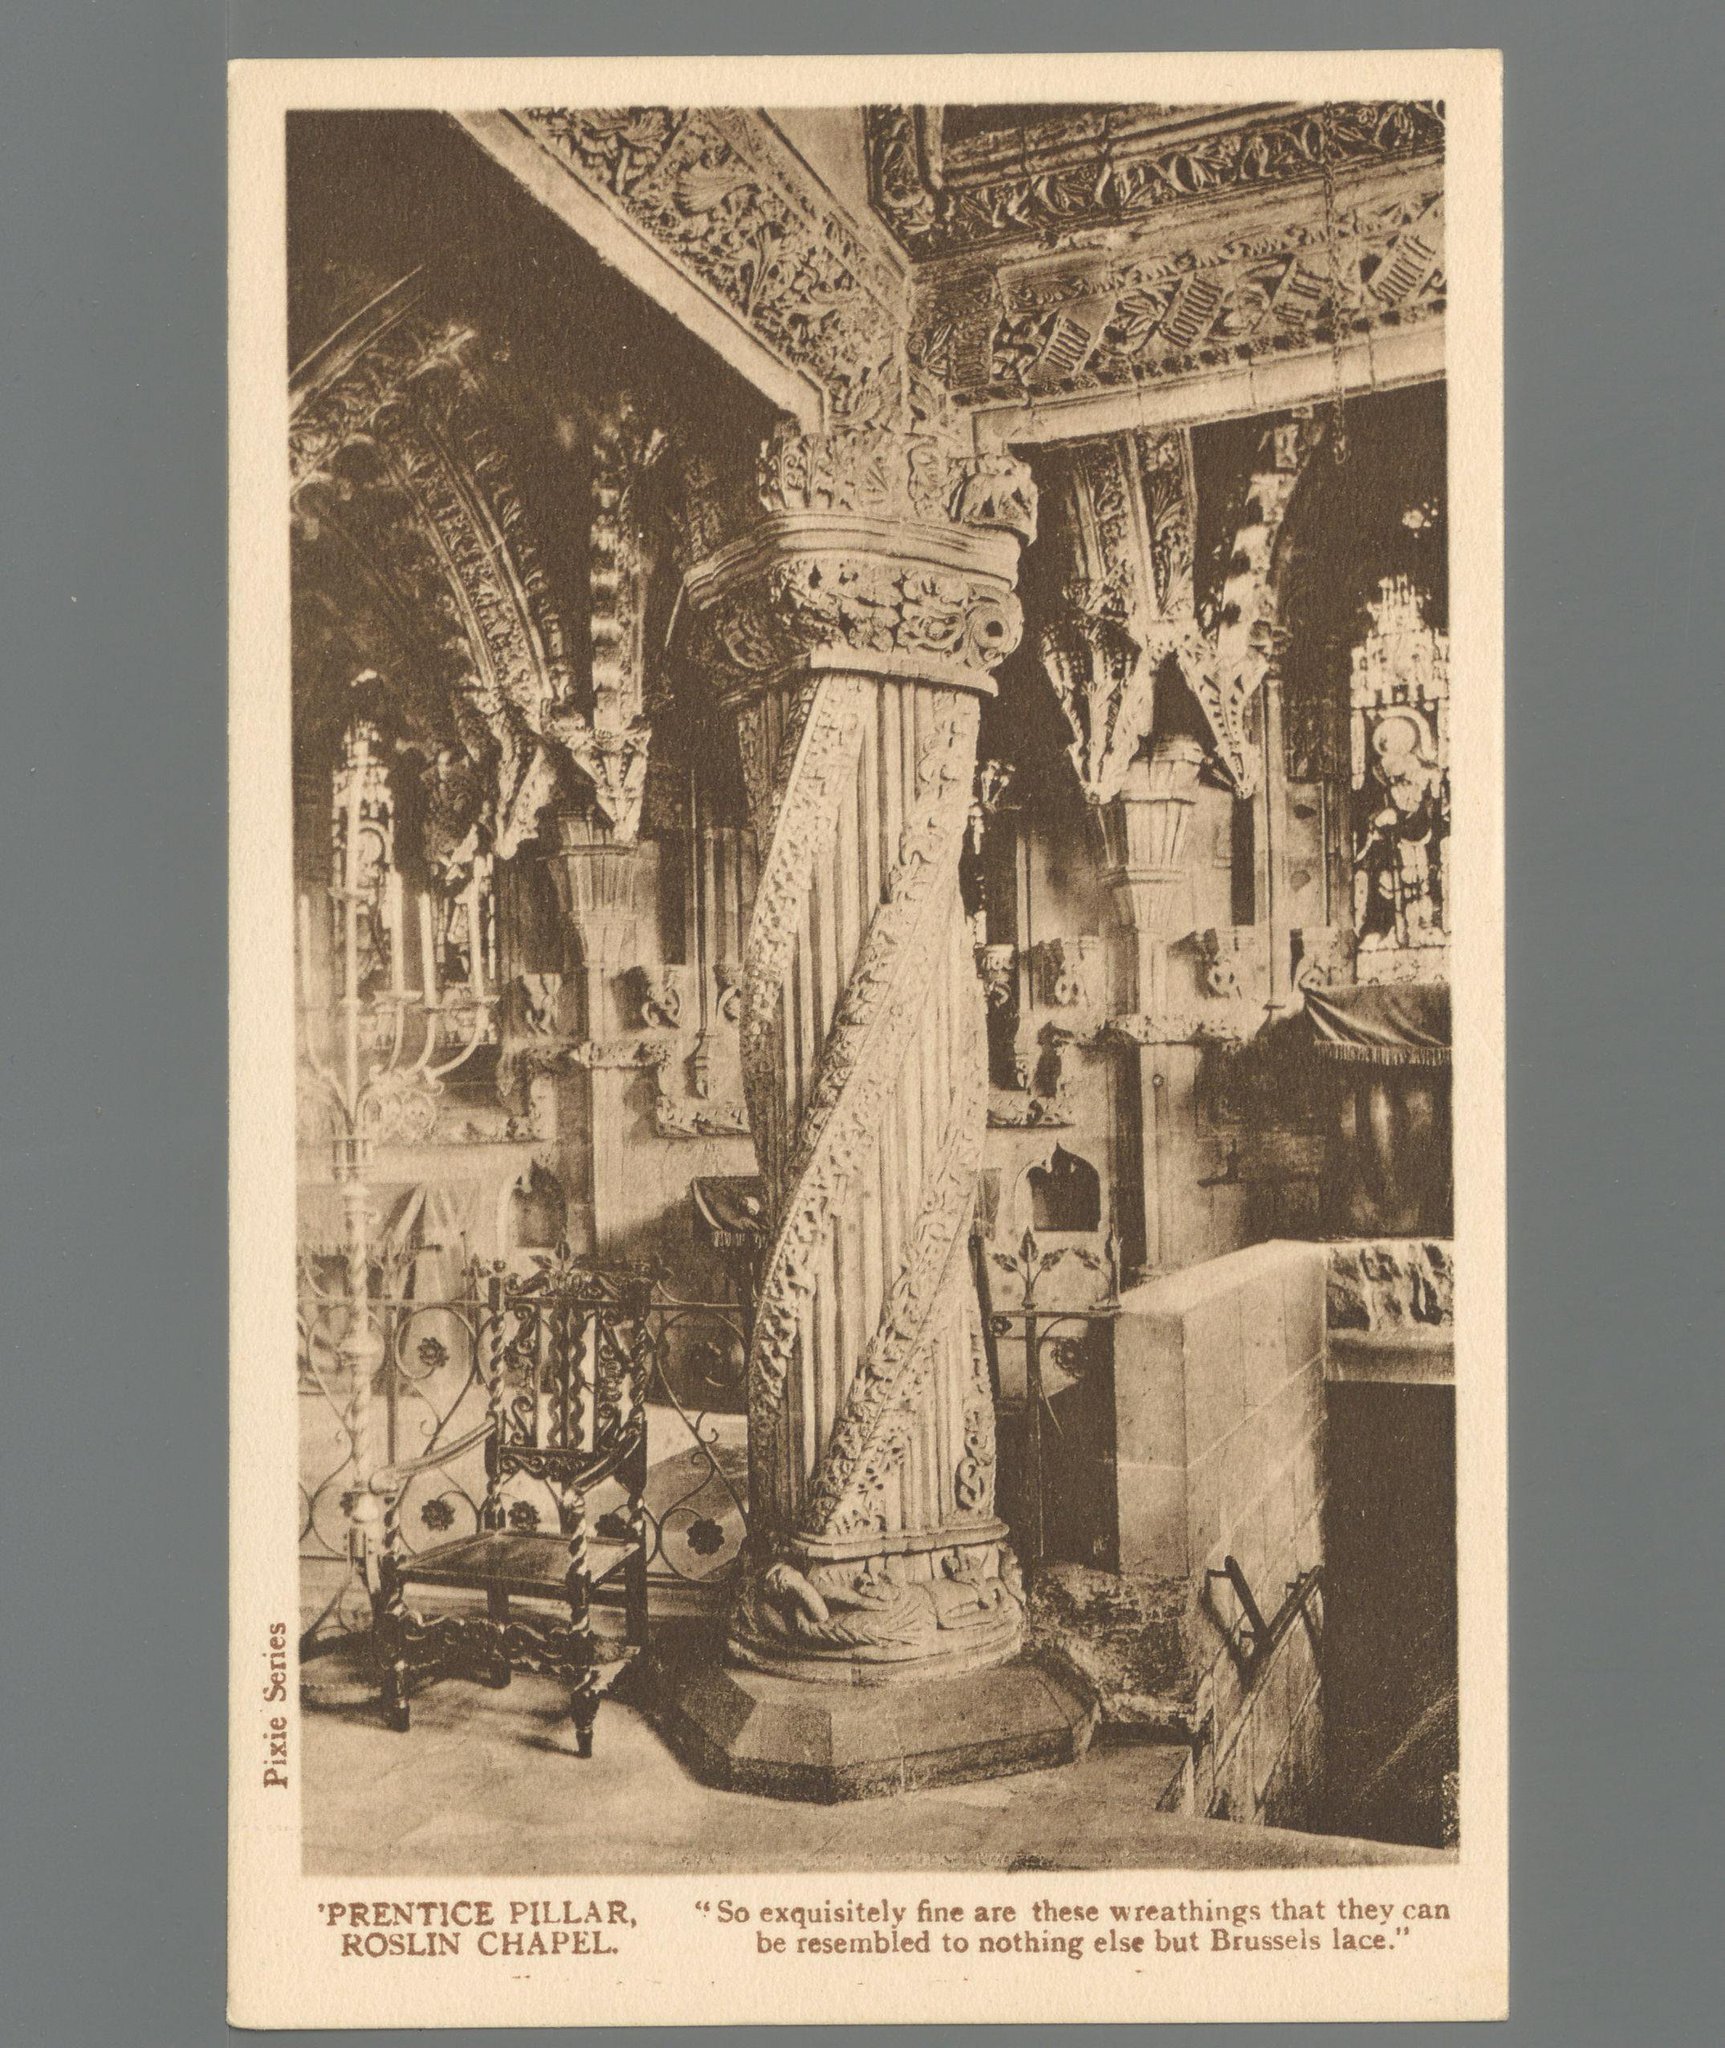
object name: ansichtkaart, prentbriefkaart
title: Pixie Series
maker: Anonymous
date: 1915-1930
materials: cardboard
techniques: photograph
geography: roslin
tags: parts of church exterior and annexes: chapel - qq - small church, chapel, column, pillar ~ architecture